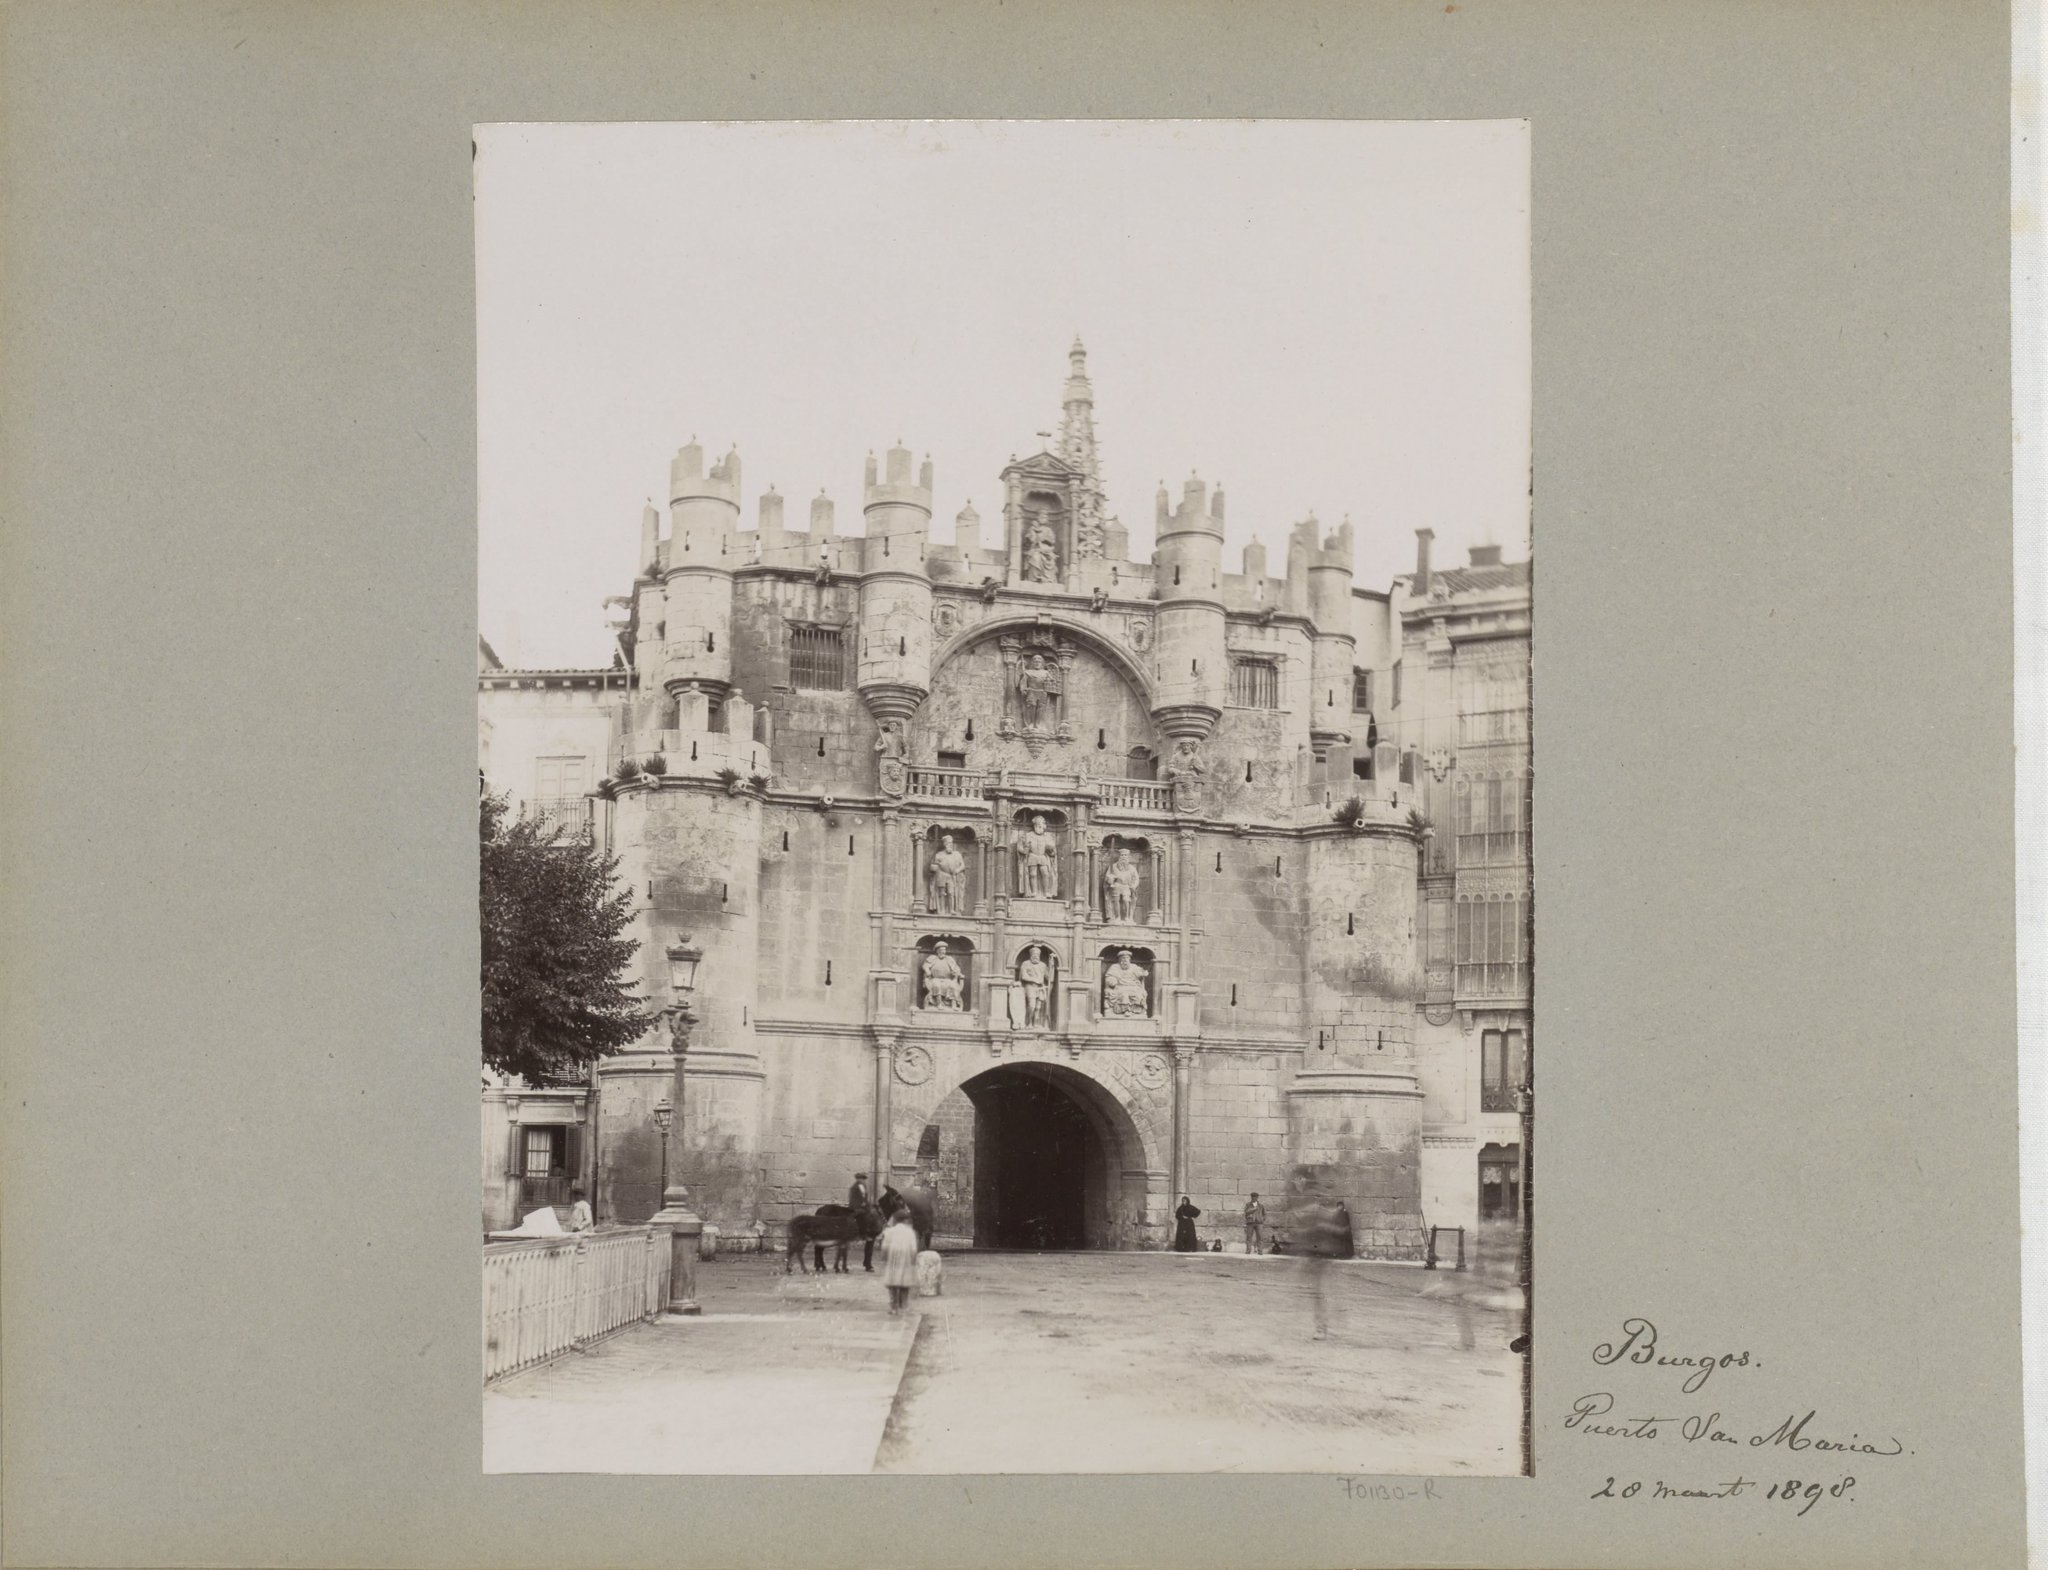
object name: photograph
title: Stadspoort Santa María in Burgos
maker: Anonymous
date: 1880-1898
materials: paper, photographic support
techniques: gelatin silver print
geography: burgos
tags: piece of sculpture, reproduction of a piece of sculpture (+ sculpture), city-gate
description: Onderdeel van Reisalbum met foto's van bezienswaardigheden in Frankrijk, Spanje, Italië, Duitsland, Zwitserland en Oostenrijk.